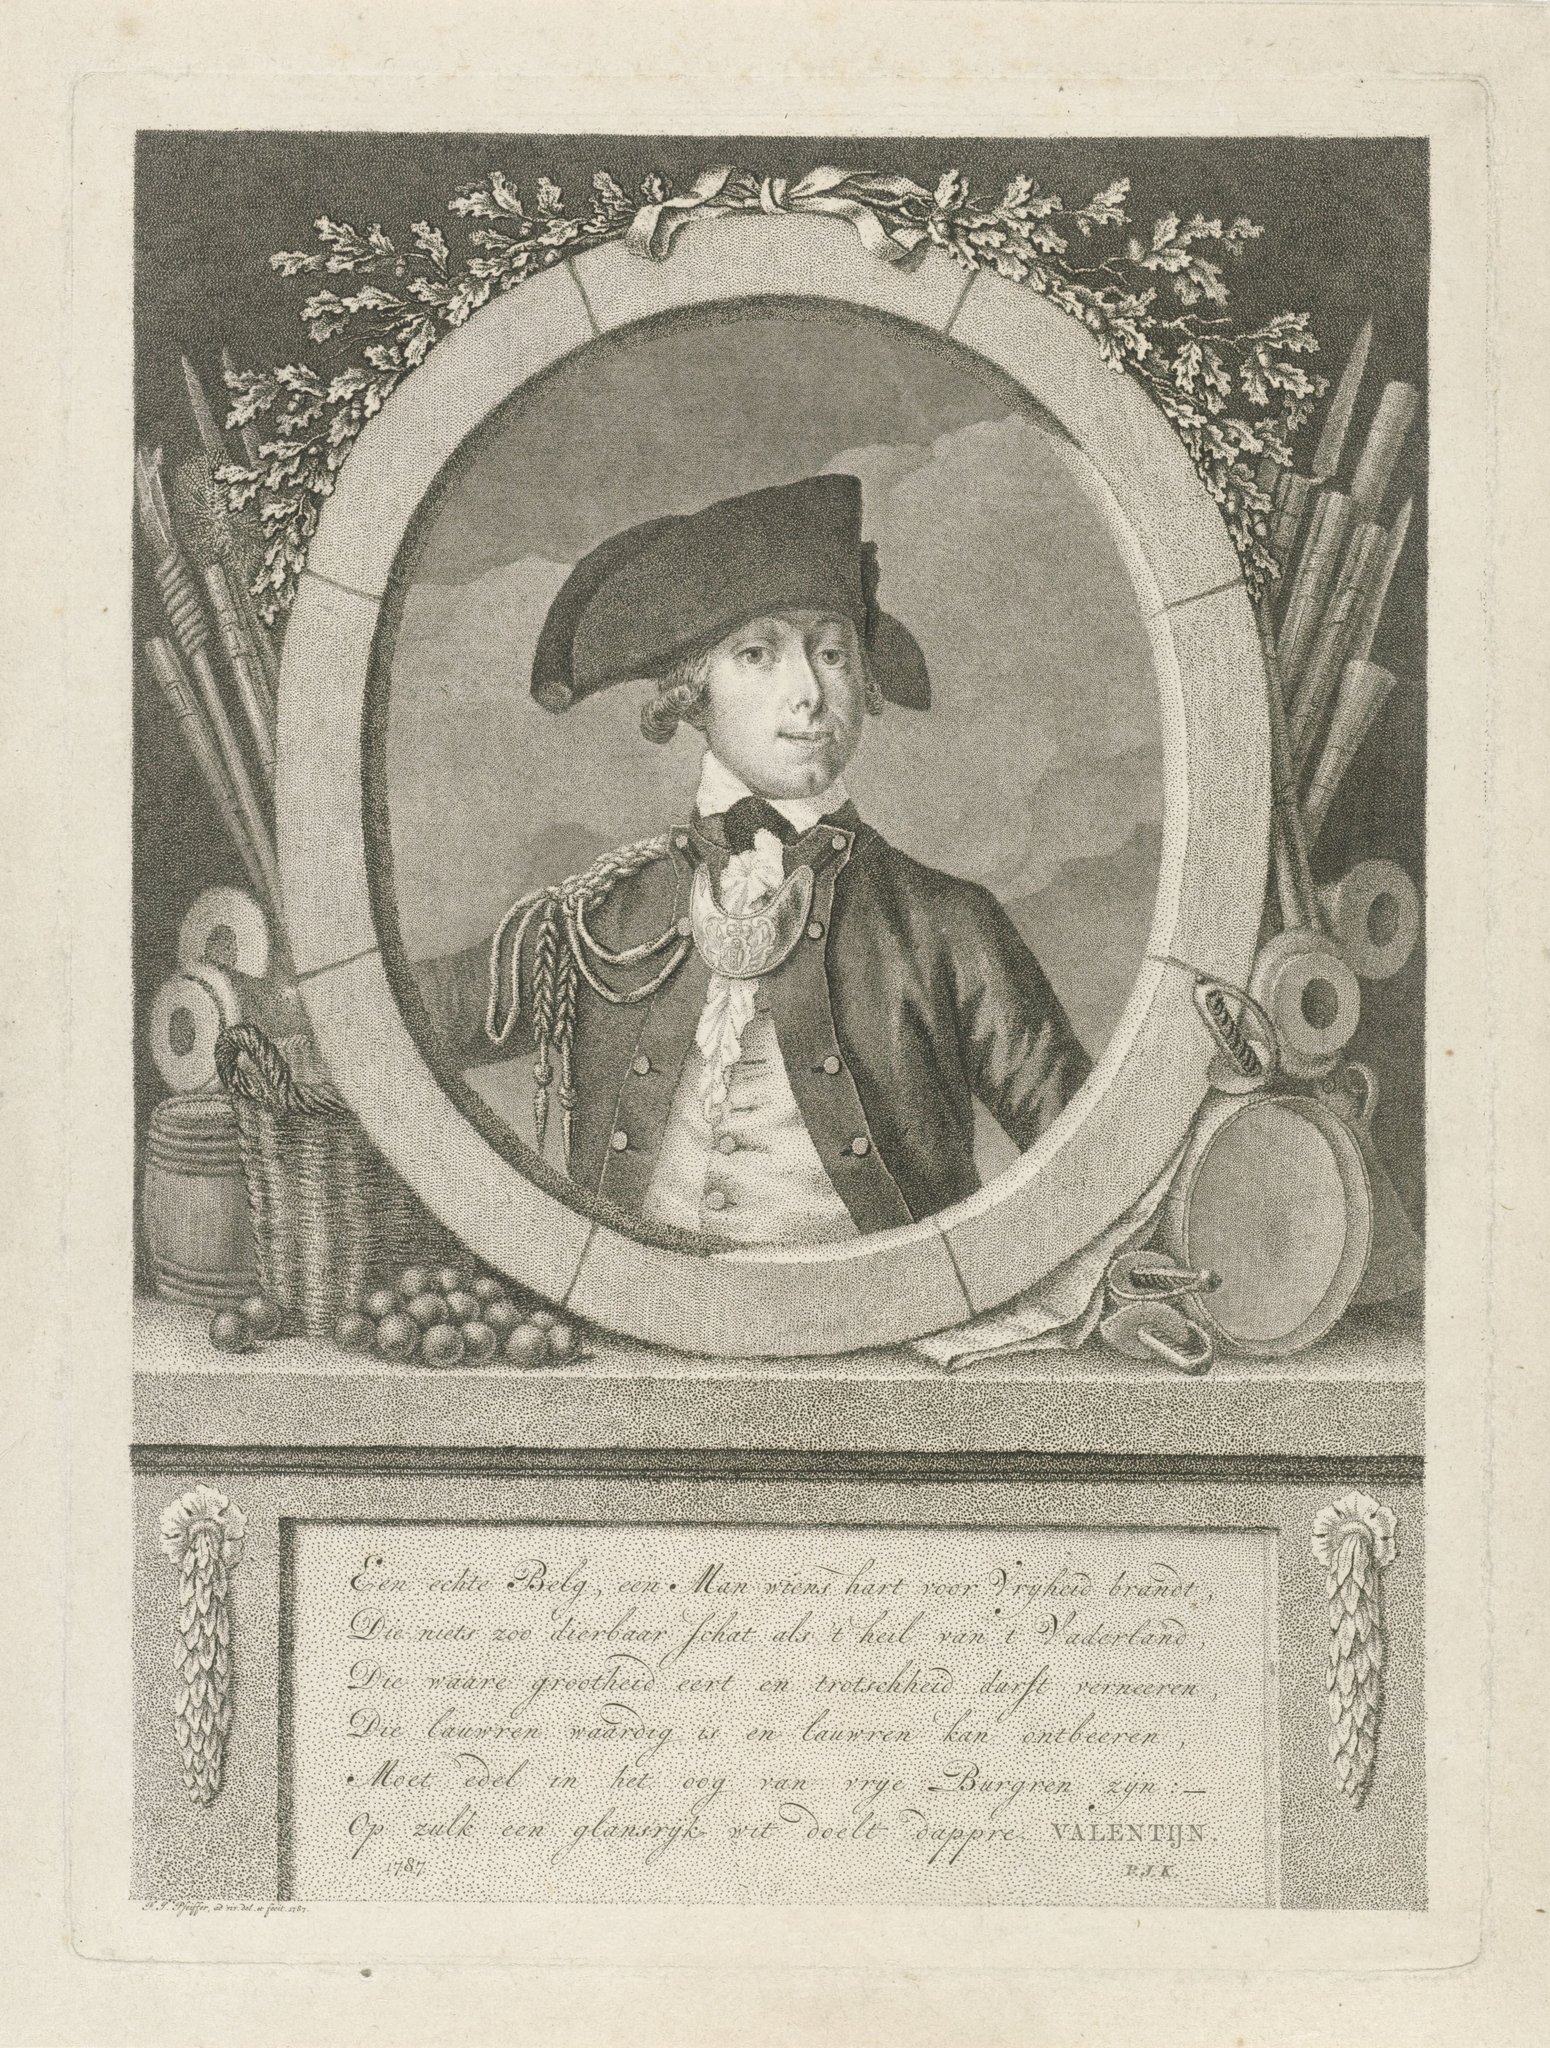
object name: print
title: Portret van Abraham Valentijn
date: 1787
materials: paper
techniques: aquatint, etching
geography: amsterdam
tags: kapitein, abraham valentijn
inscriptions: collector's mark: Lugt 2760, collector's mark: Lugt 2228